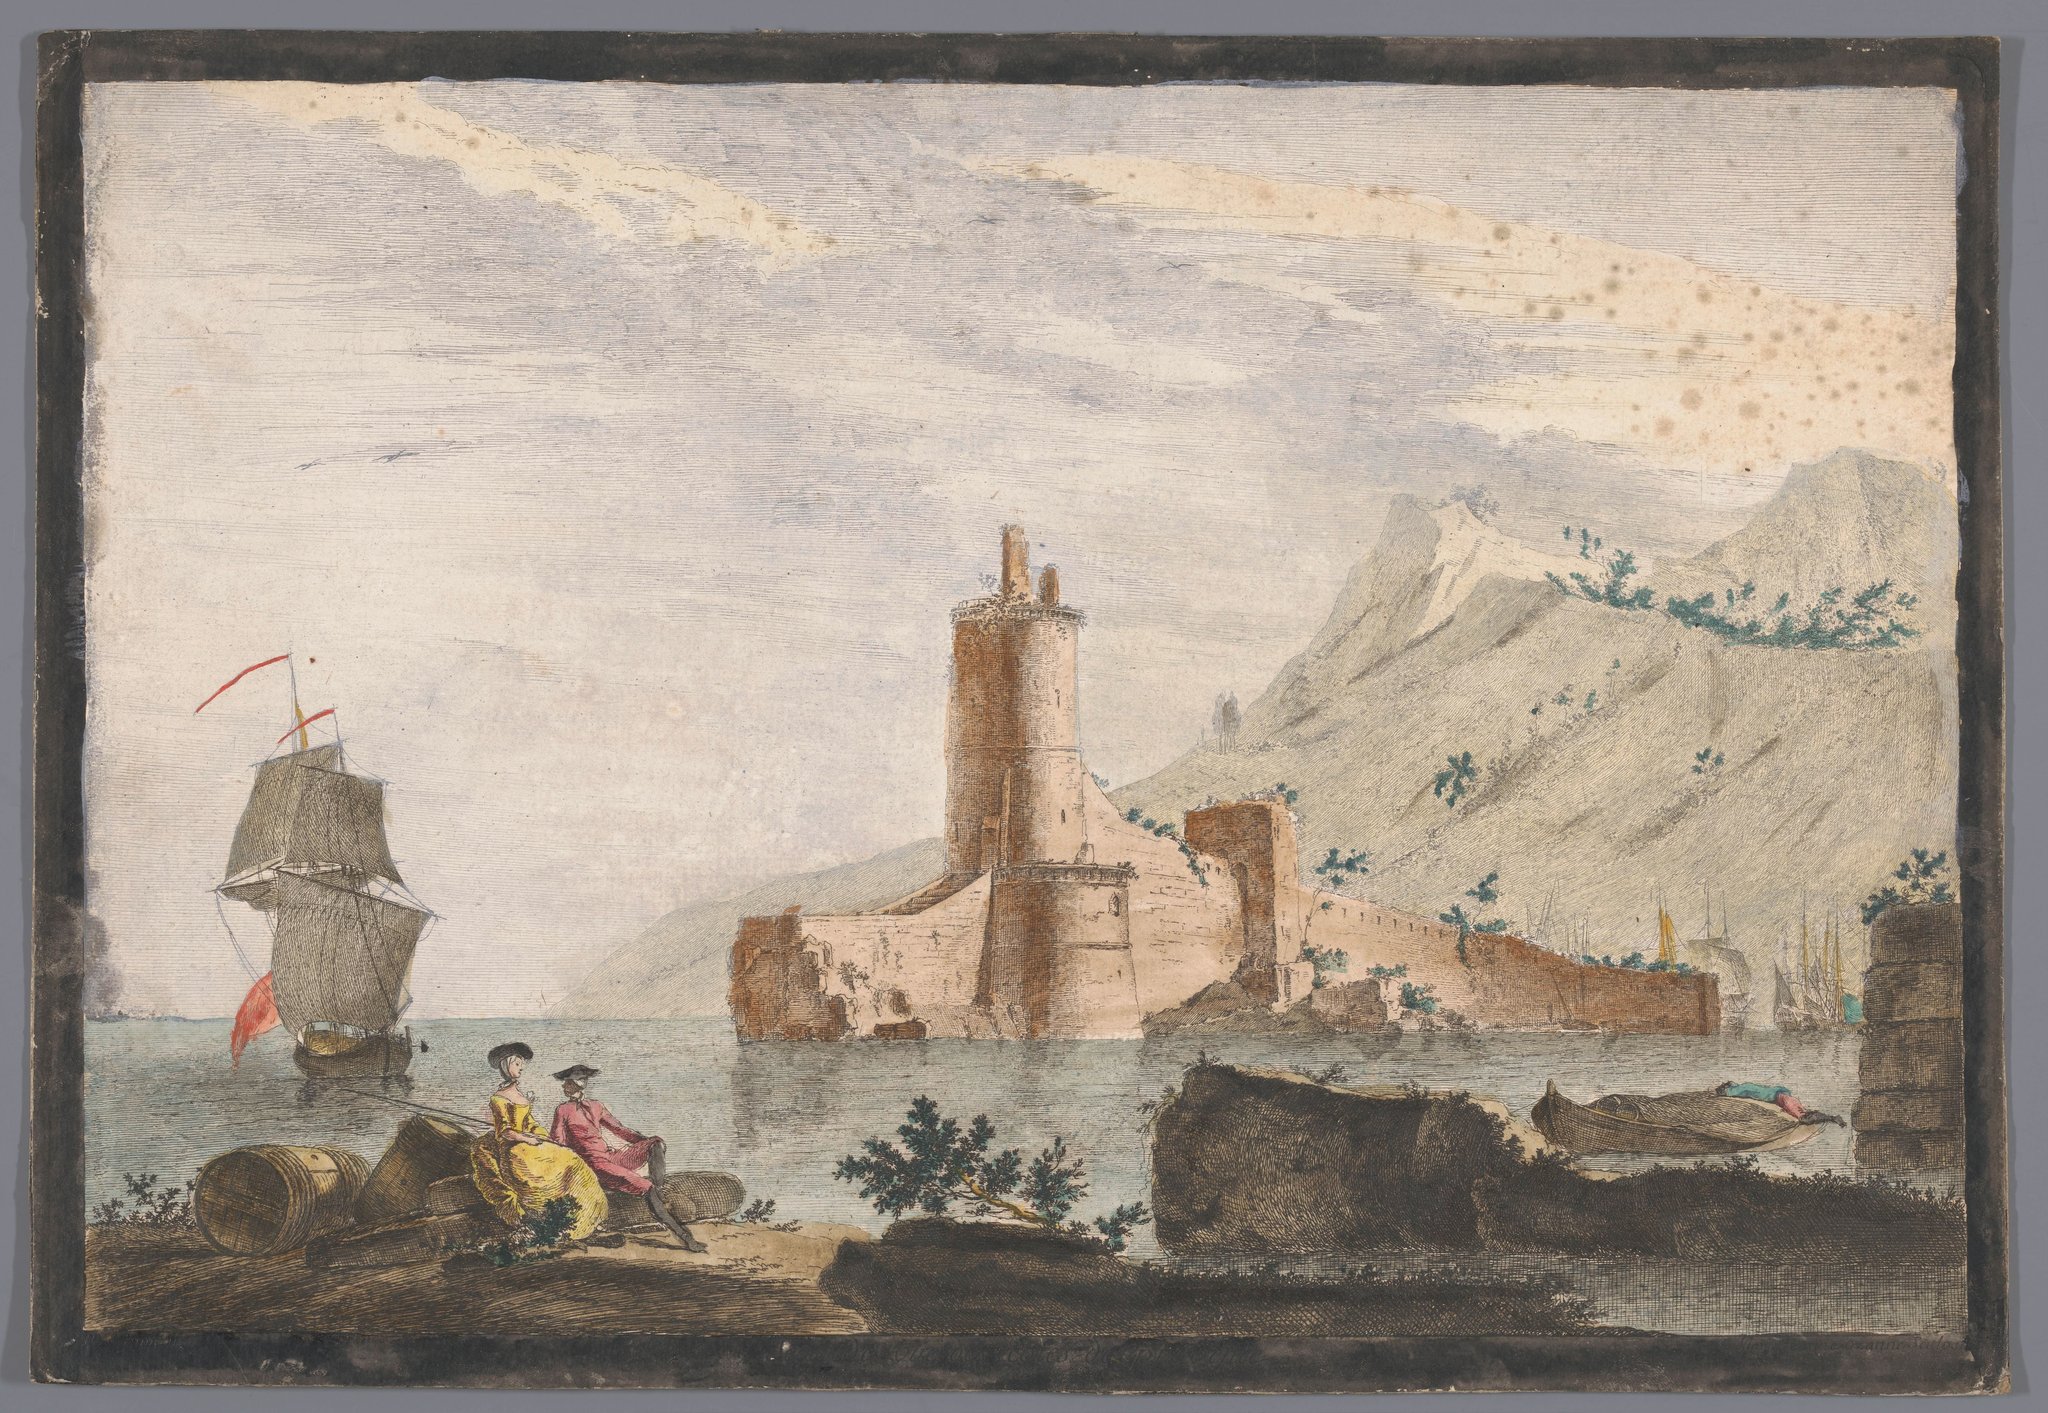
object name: opticaprent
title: Gezicht op een haven met een toren in de Provence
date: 1700-1799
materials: cardboard, paper, watercolor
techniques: brush, etching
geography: france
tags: harbour, sailing-ship, sailing-boat, rowing-boat, canoe, etc., monumental adornments (in city), sea (seascape) (+ landscape with figures, staffage)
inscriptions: collector's mark: Lugt 2233